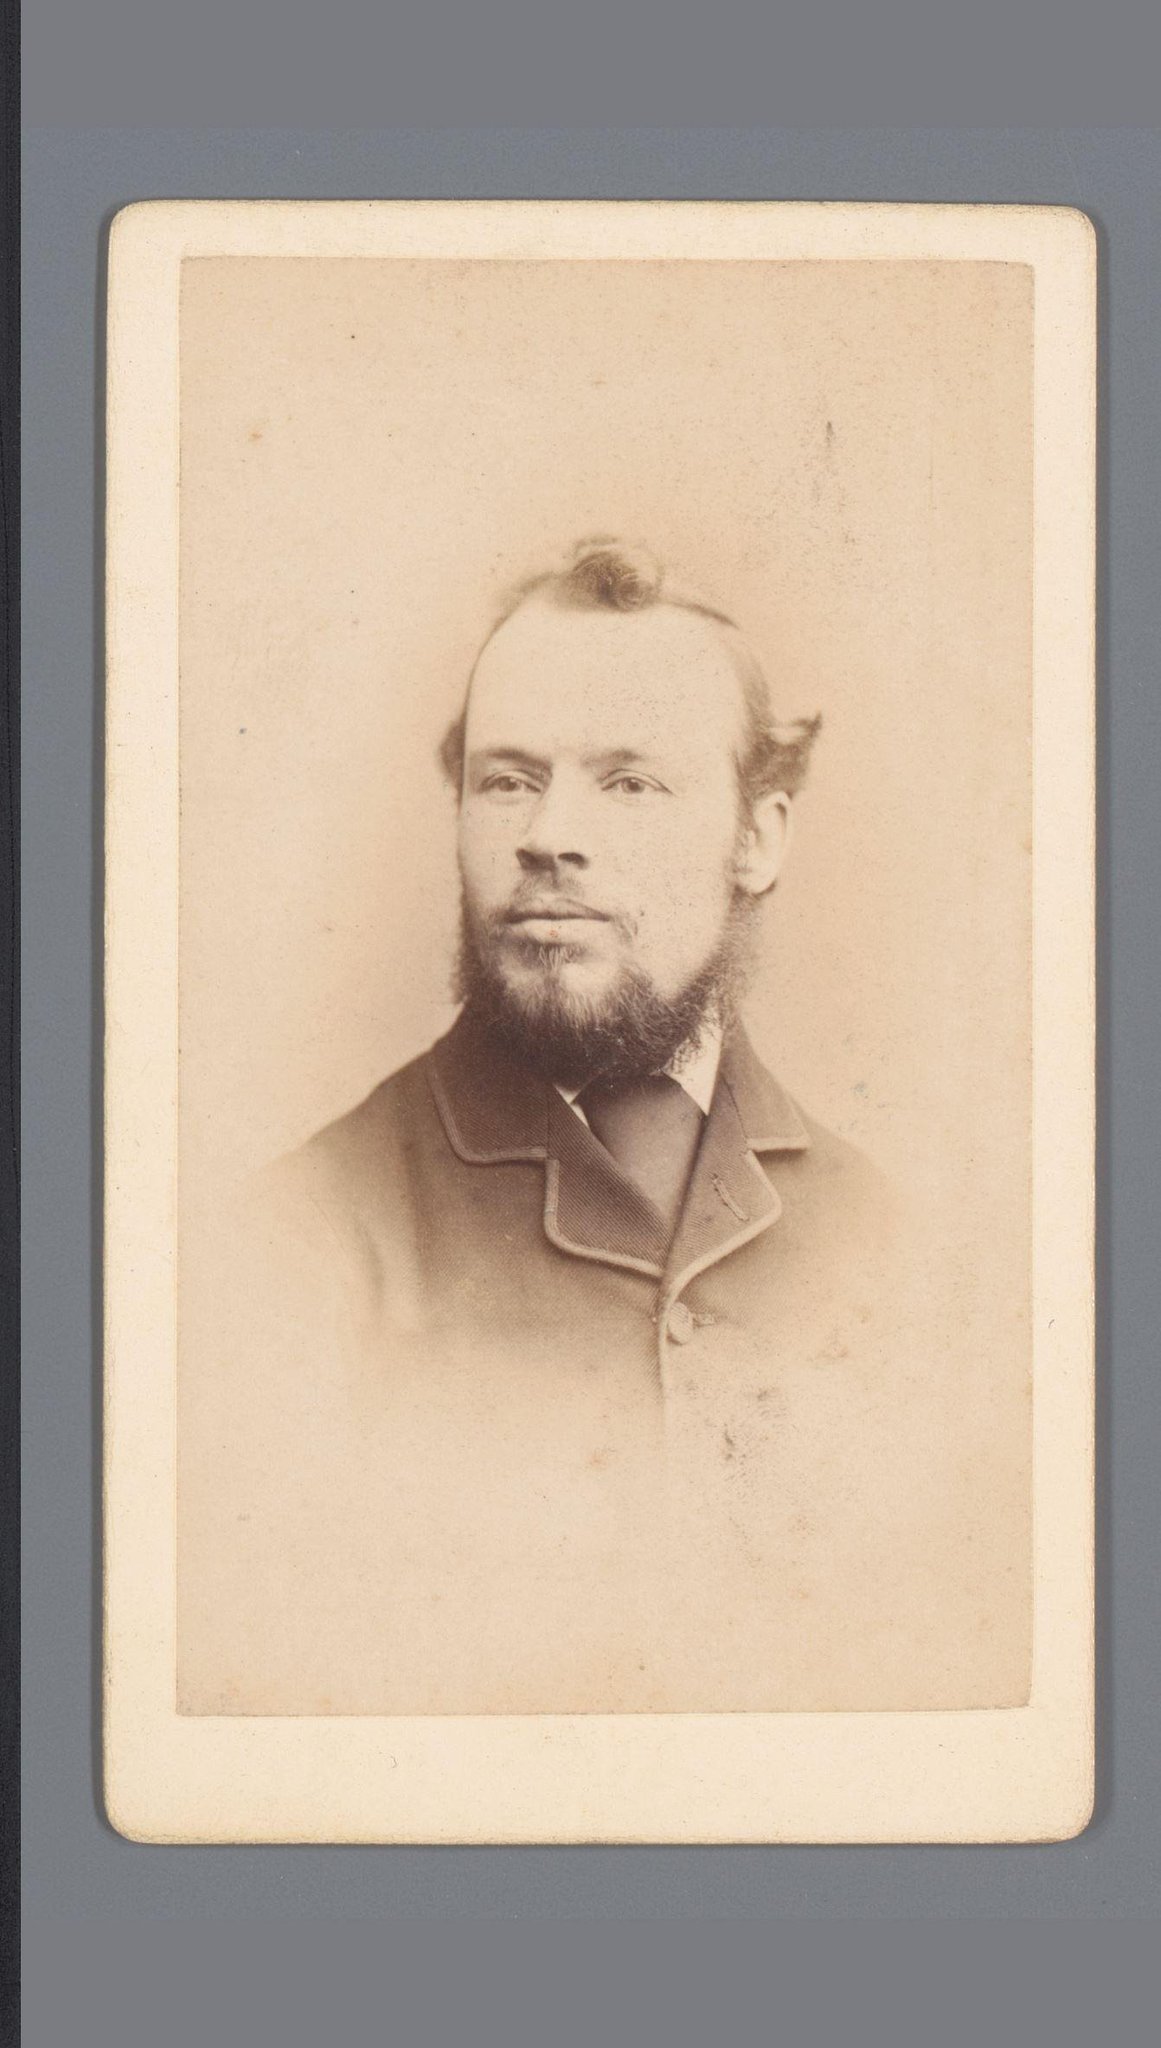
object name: photograph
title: Portret van een onbekende man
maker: john george kirby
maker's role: fotograaf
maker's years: 1849-1913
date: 1855-1885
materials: cardboard, paper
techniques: albumen print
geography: london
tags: adult man, anonymous historical person portrayed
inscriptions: inscription: ‘Negatives kept. Copies or Enlargements/ can be had at any time.’, inscription: ‘W. W. Hughes & Co. London E. C.’, address: ‘295, Edgware Road/ W./ LONDON.’